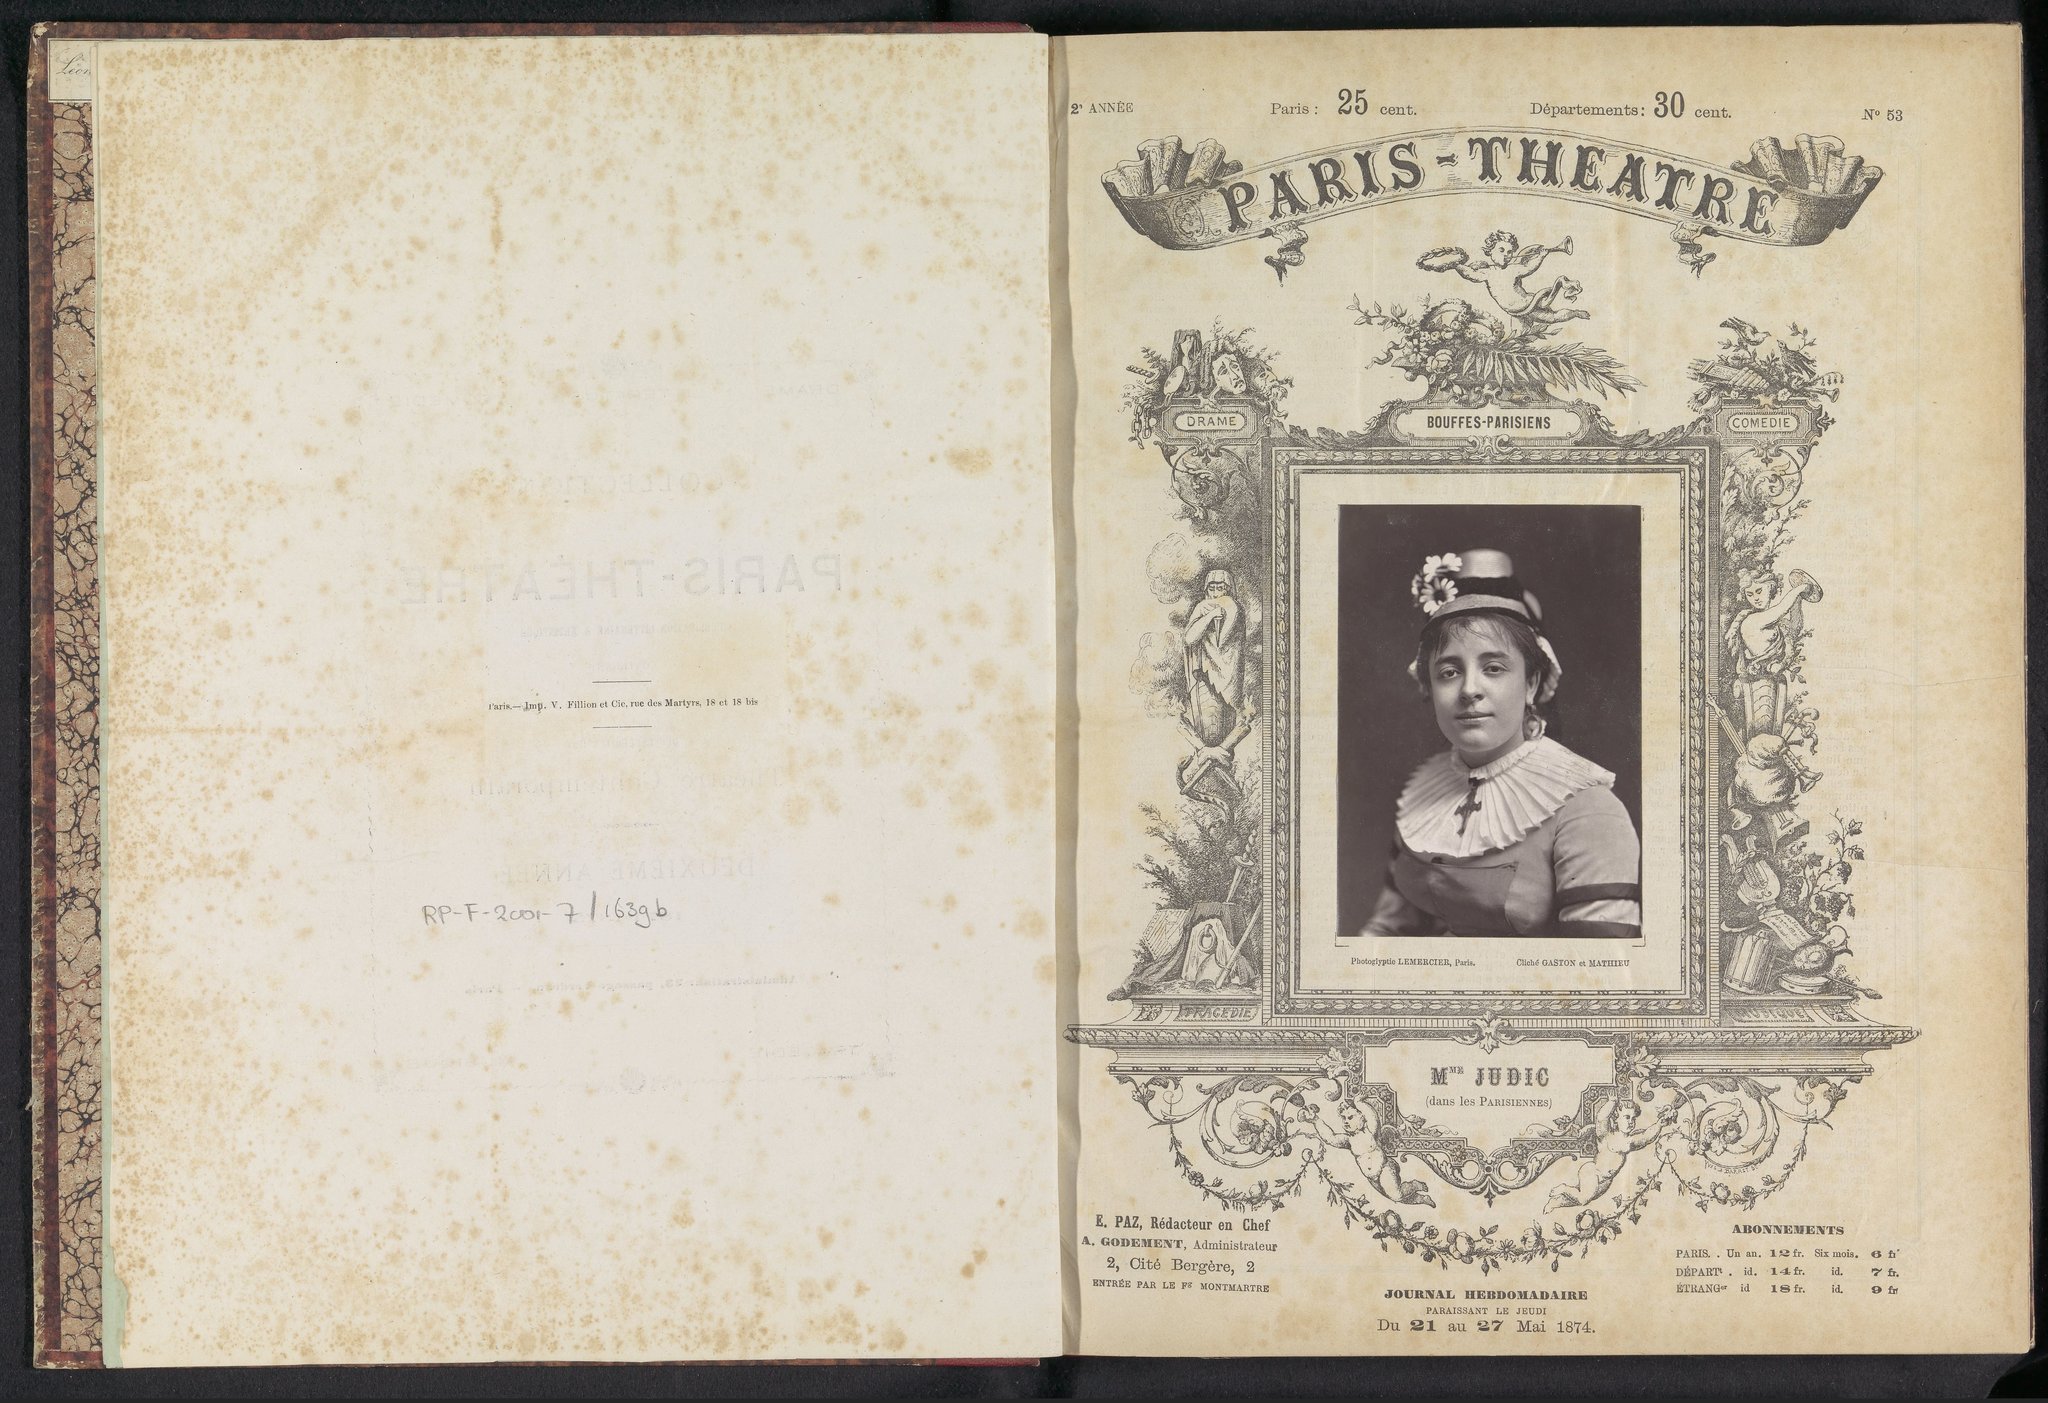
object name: page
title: Mme Judic (dans Les Parisiennes)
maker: joseph rose lemercier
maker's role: printer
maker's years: 1803-1887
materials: paper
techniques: woodburytype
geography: france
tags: portrait of actor, actress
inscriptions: inscription: ‘Journal hebdomadaire paraissant le jeudi Du 21 au 27 Mai 1874.’, number: ‘No 53’